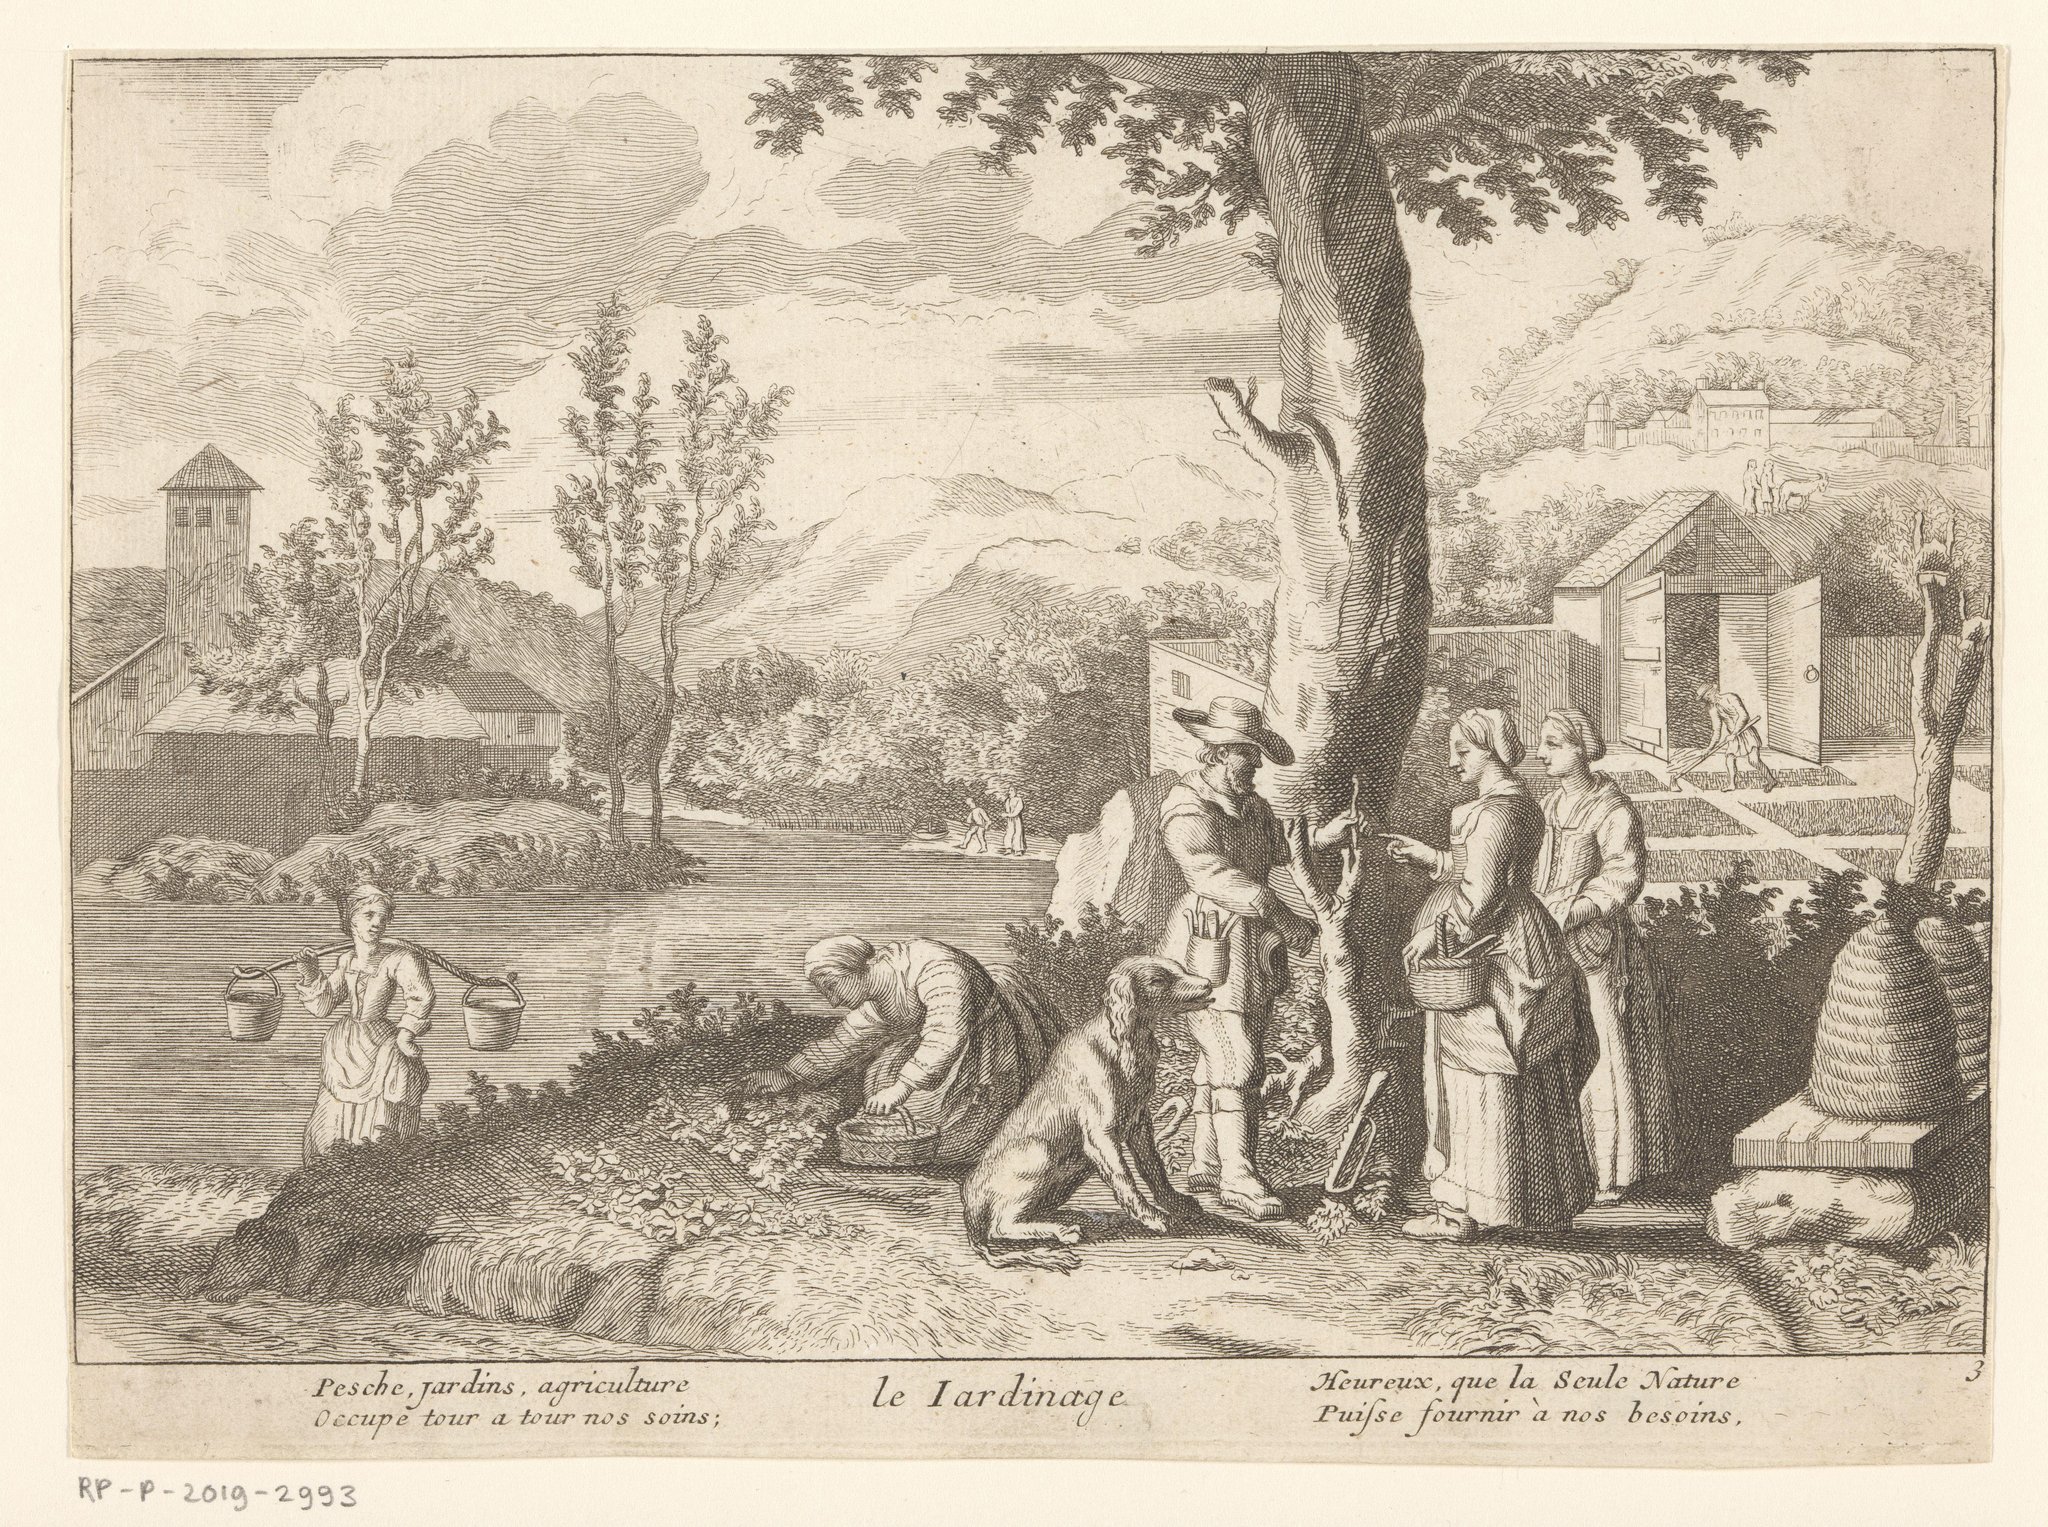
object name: print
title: Landelijke en pastorale scènes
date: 1661-1726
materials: paper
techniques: engraving, etching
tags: garden, bee-hive, gardening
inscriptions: collector's mark: Lugt 2228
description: Maakt deel uit van een zestiendelige serie met landelijke en pastorale scènes, uitgegeven door Gerard Valck.